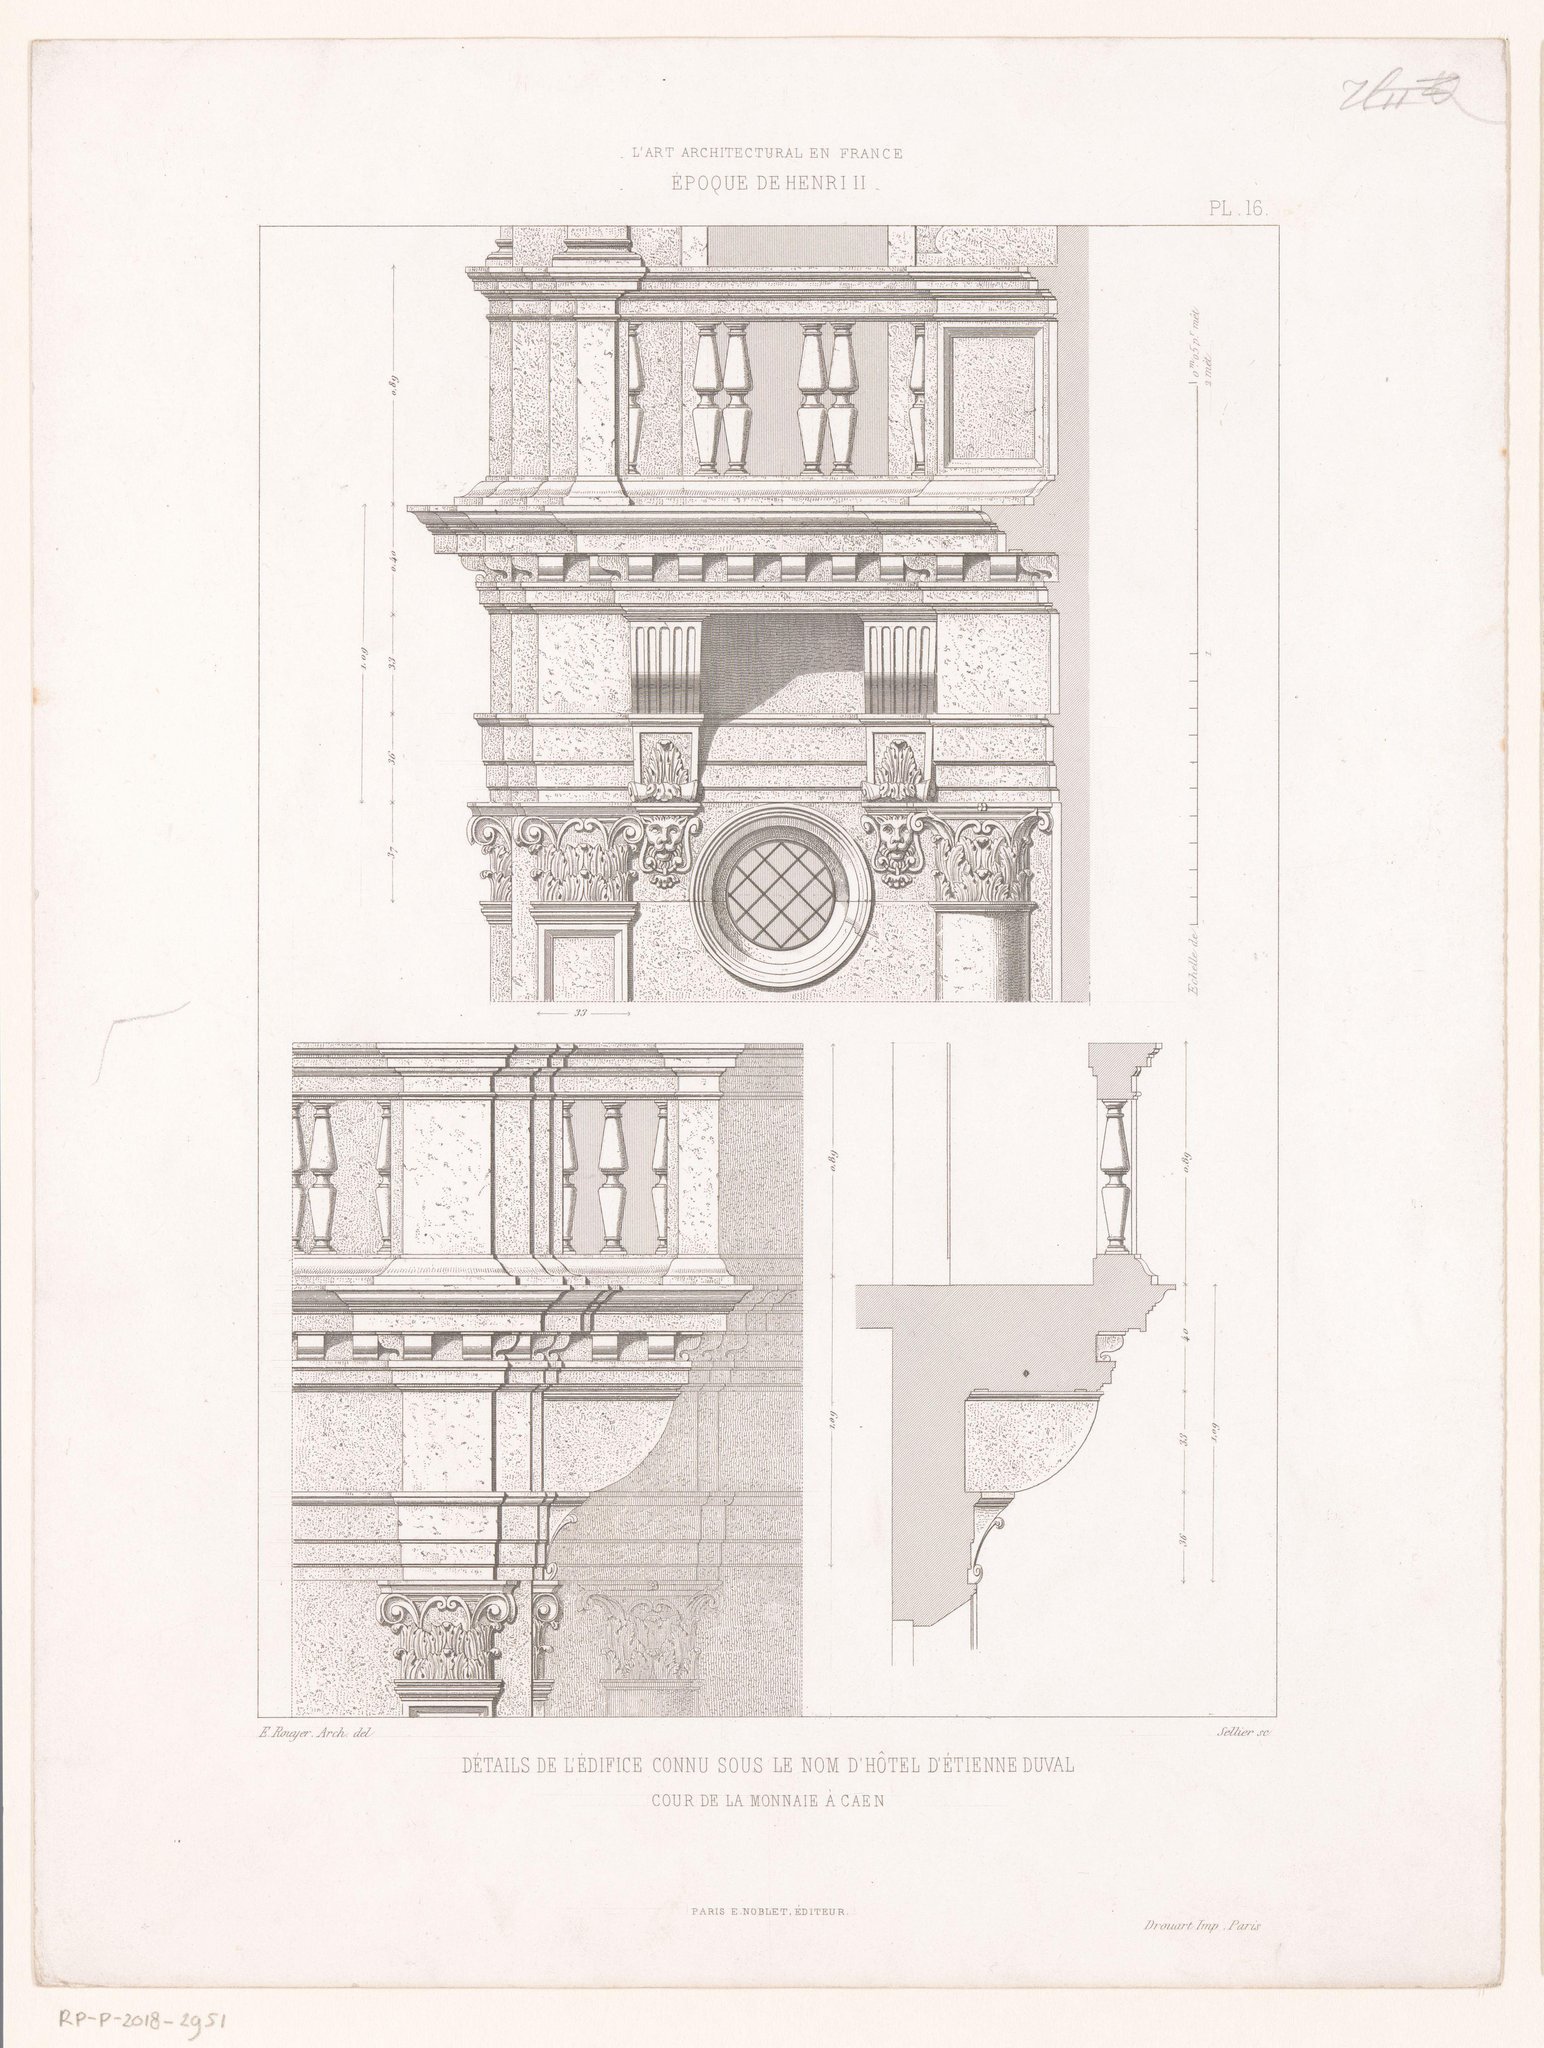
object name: print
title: Détails de l'édifice connu sous le nom d'hotel d'etienne duval cour de la Monnaie à caen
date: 1866-1867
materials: paper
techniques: lithograph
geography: paris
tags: architectural detail, civic architecture; edifices; dwellings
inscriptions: collector's mark: Lugt 2228, collector's mark: Lugt 3937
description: Prent uit: L'art architectural en France: époques Henri II, Louis XIII, Louis XIV, Louis XV, et Louis XVI, Parijs: Noblet et Baudry, 1866-1867. Het gebouw staat in Caen en is ontworpen door Etienne Duval.